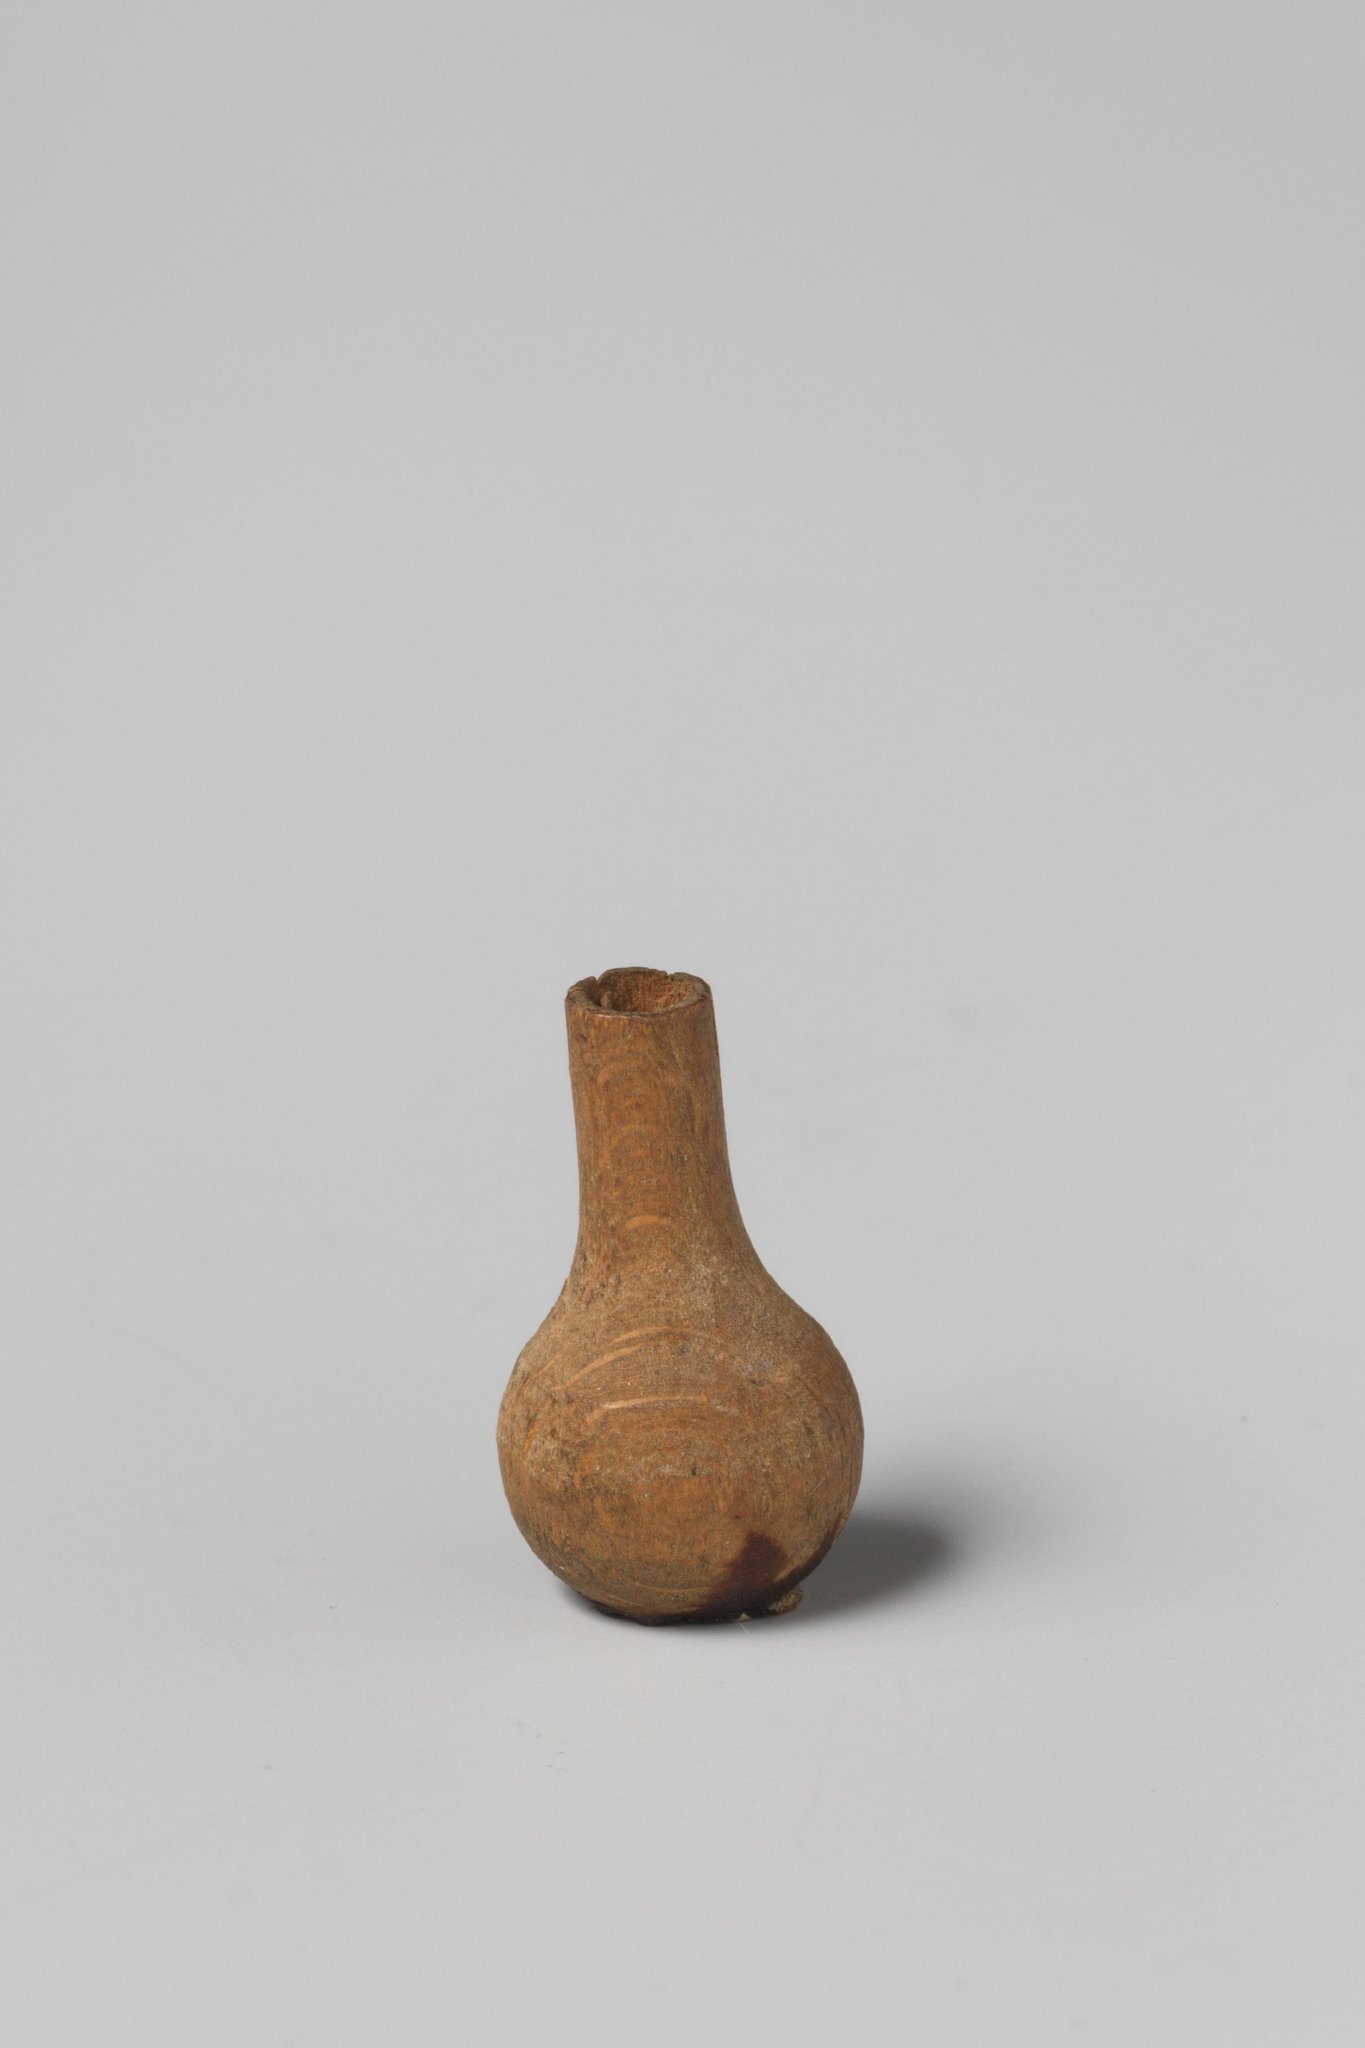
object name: bottle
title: Fles, gedraaid van esdoornhout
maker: Anonymous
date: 1675-1699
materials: wood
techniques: turning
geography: amsterdam